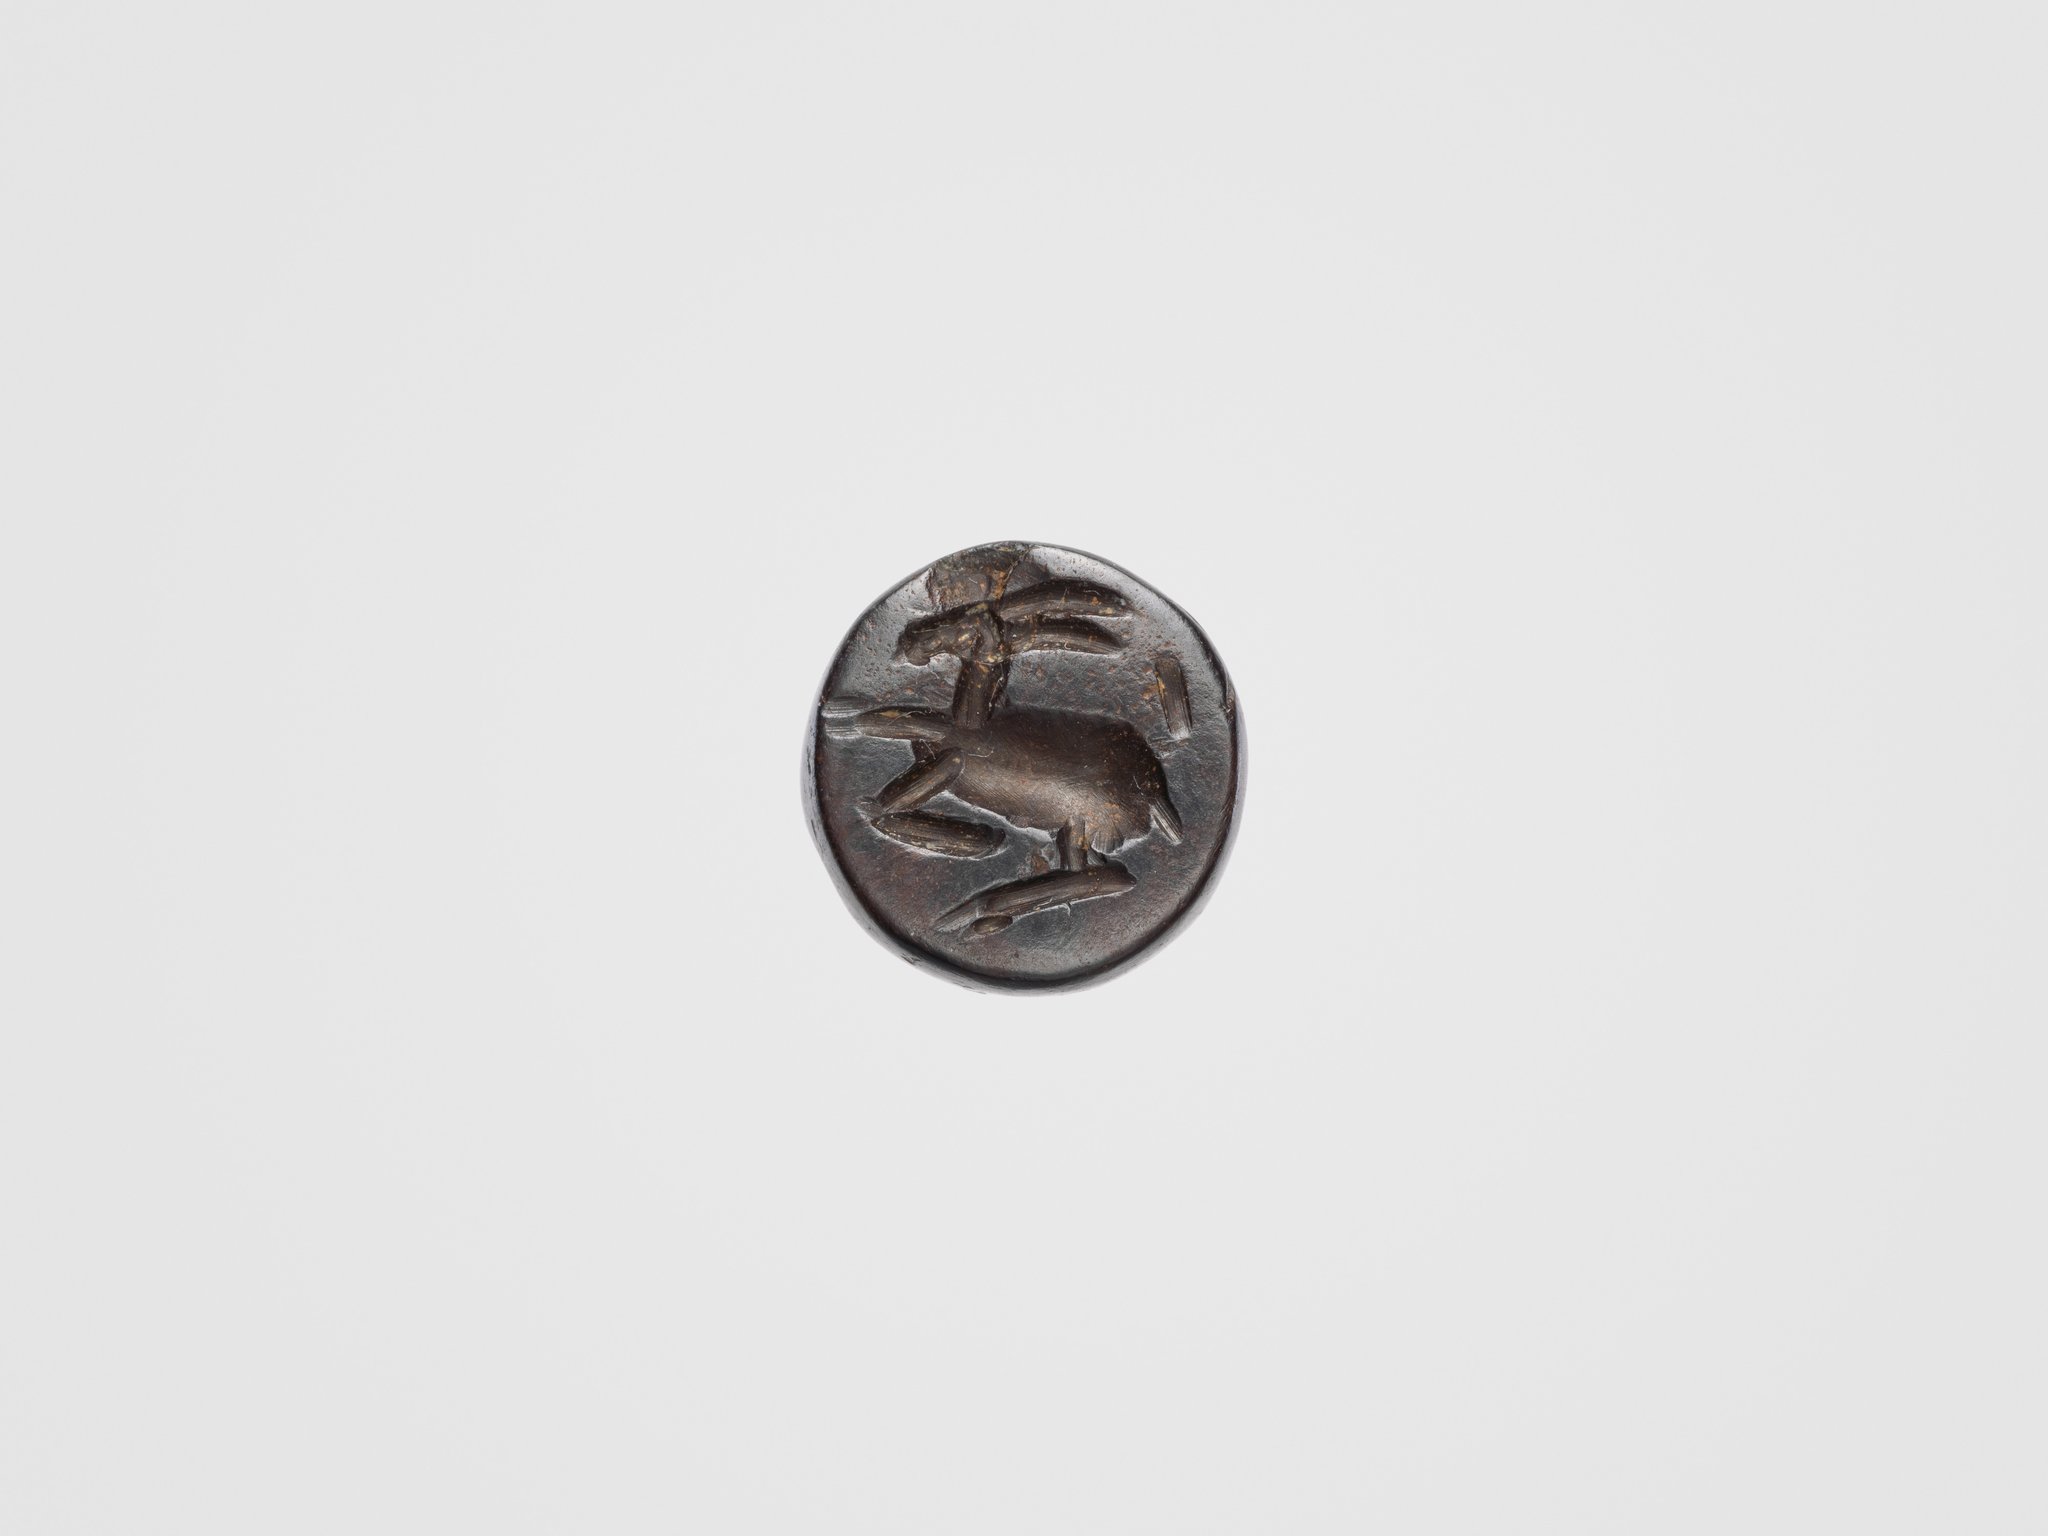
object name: stamp seal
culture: sasanian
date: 201-700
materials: mineral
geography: iran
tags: animals